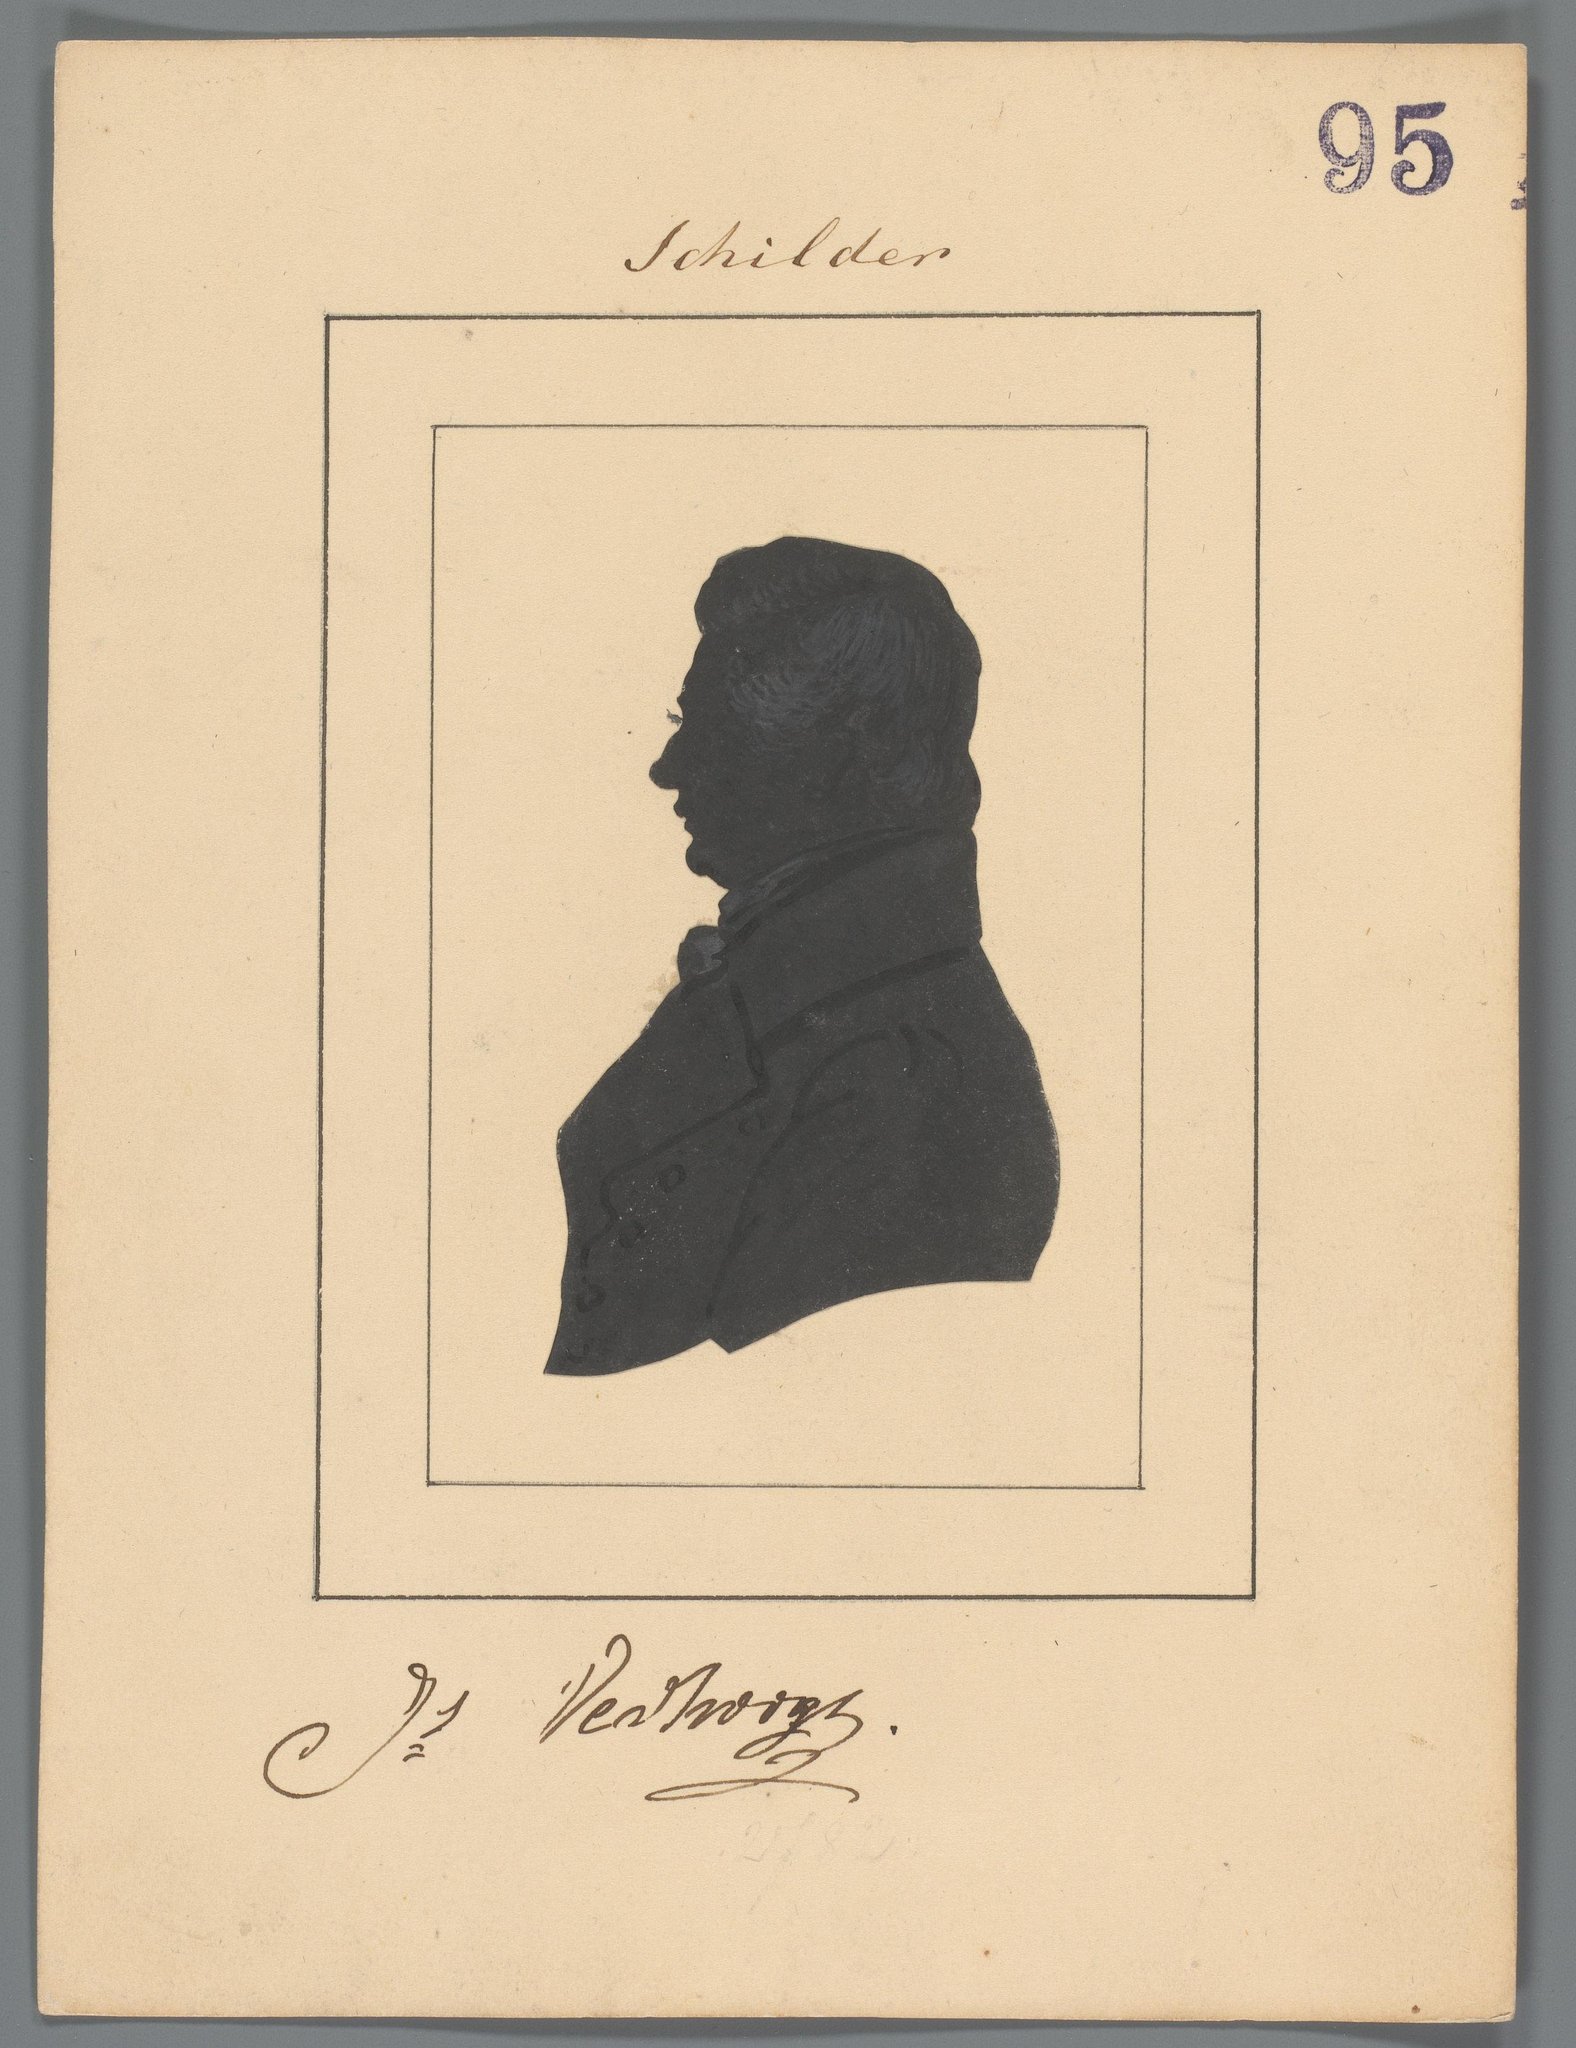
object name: cut paper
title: Silhouetportret van Johannes Verhoogh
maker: elisabeth alida haanen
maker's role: draughtsman, print maker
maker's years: 1809-1845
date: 1819-1845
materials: ink, paint, paper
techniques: brush, snipping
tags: rotterdam, painter, johannes verhoogh, historical persons, portrait, self-portrait of painter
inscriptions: inscription: ‘Schilder’, number: ‘95’, collector's mark: ‘Ex-libris van Beresteyn’, number: ‘13971’, inscription: ‘Neg. D. 1795’, inscription: ‘Js Verhoogh’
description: Met onder het portret de handtekening van de geportretteerde.